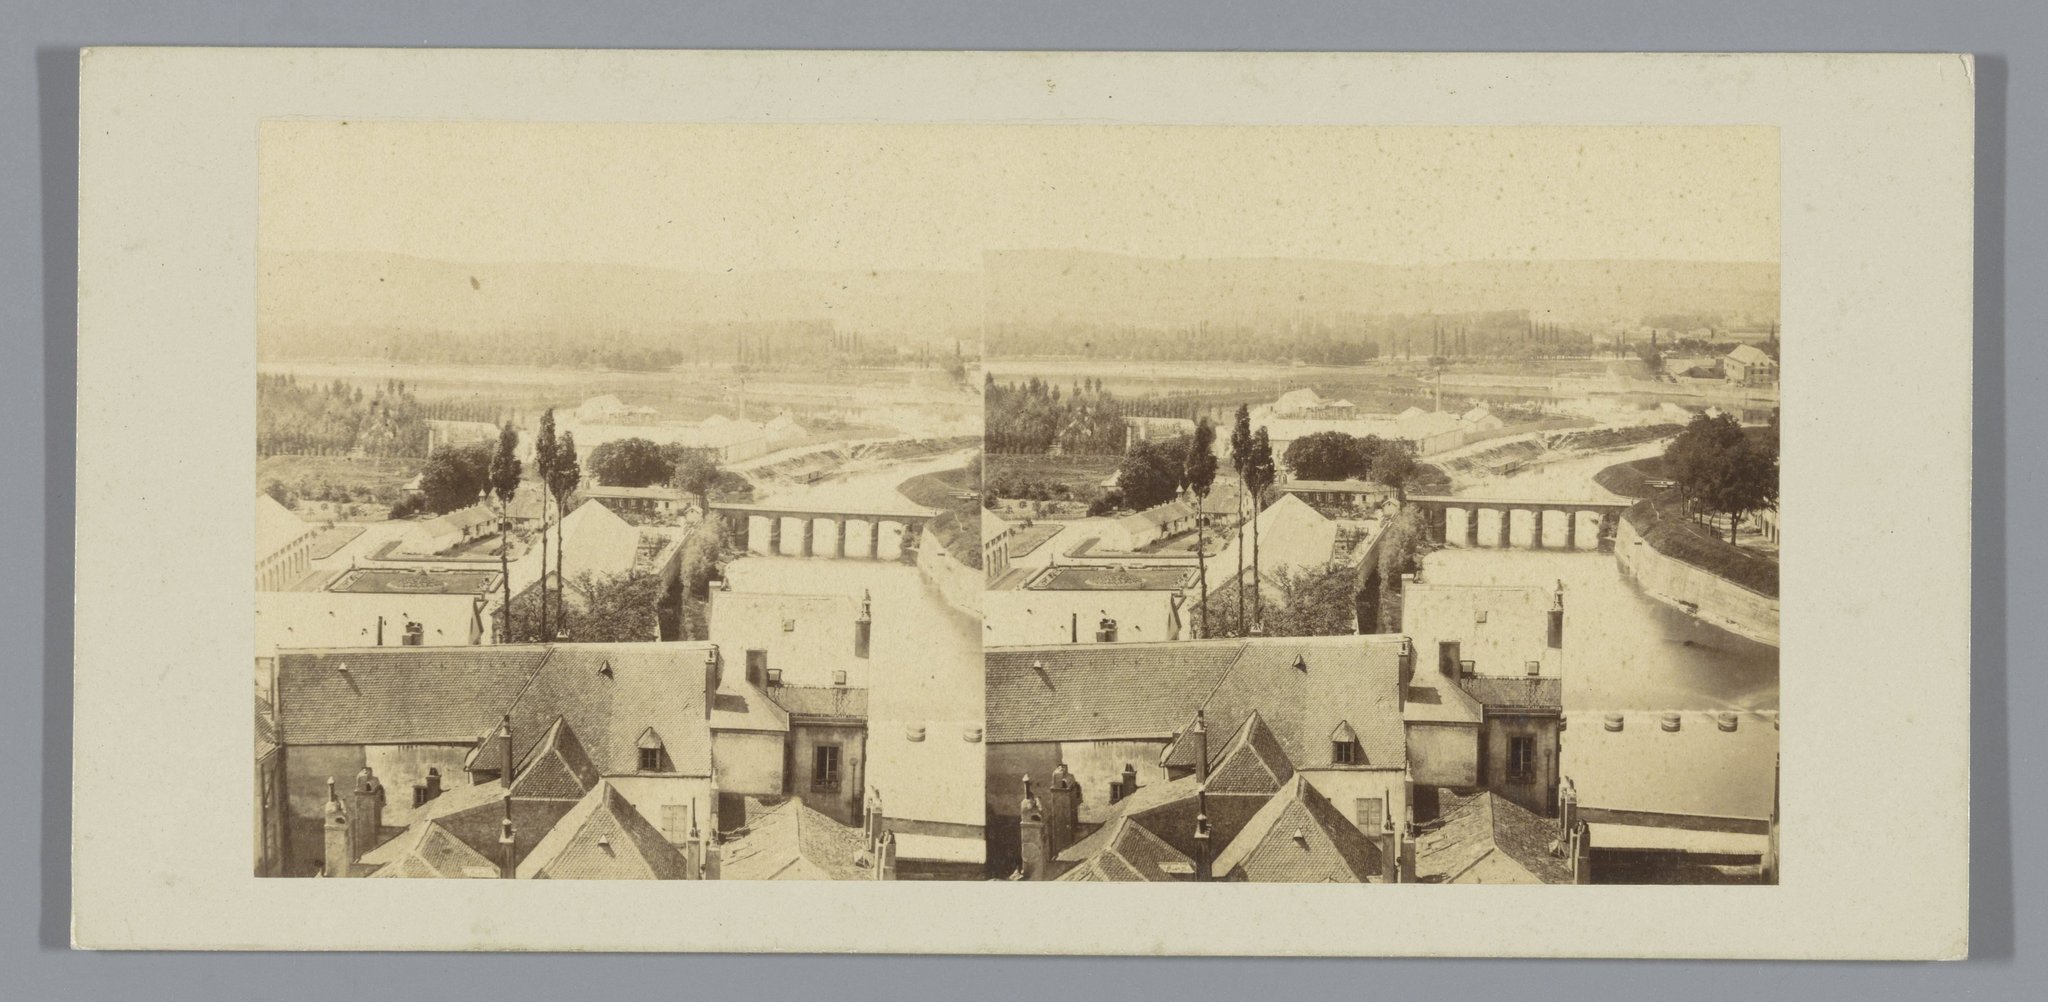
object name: stereograph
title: Gezicht op een stad aan een rivier, vermoedelijk Metz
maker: Anonymous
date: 1860-1875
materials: cardboard, photographic support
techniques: albumen print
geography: france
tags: city-view, and landscape with man-made constructions, river, france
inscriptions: inscription: ‘Metz?’